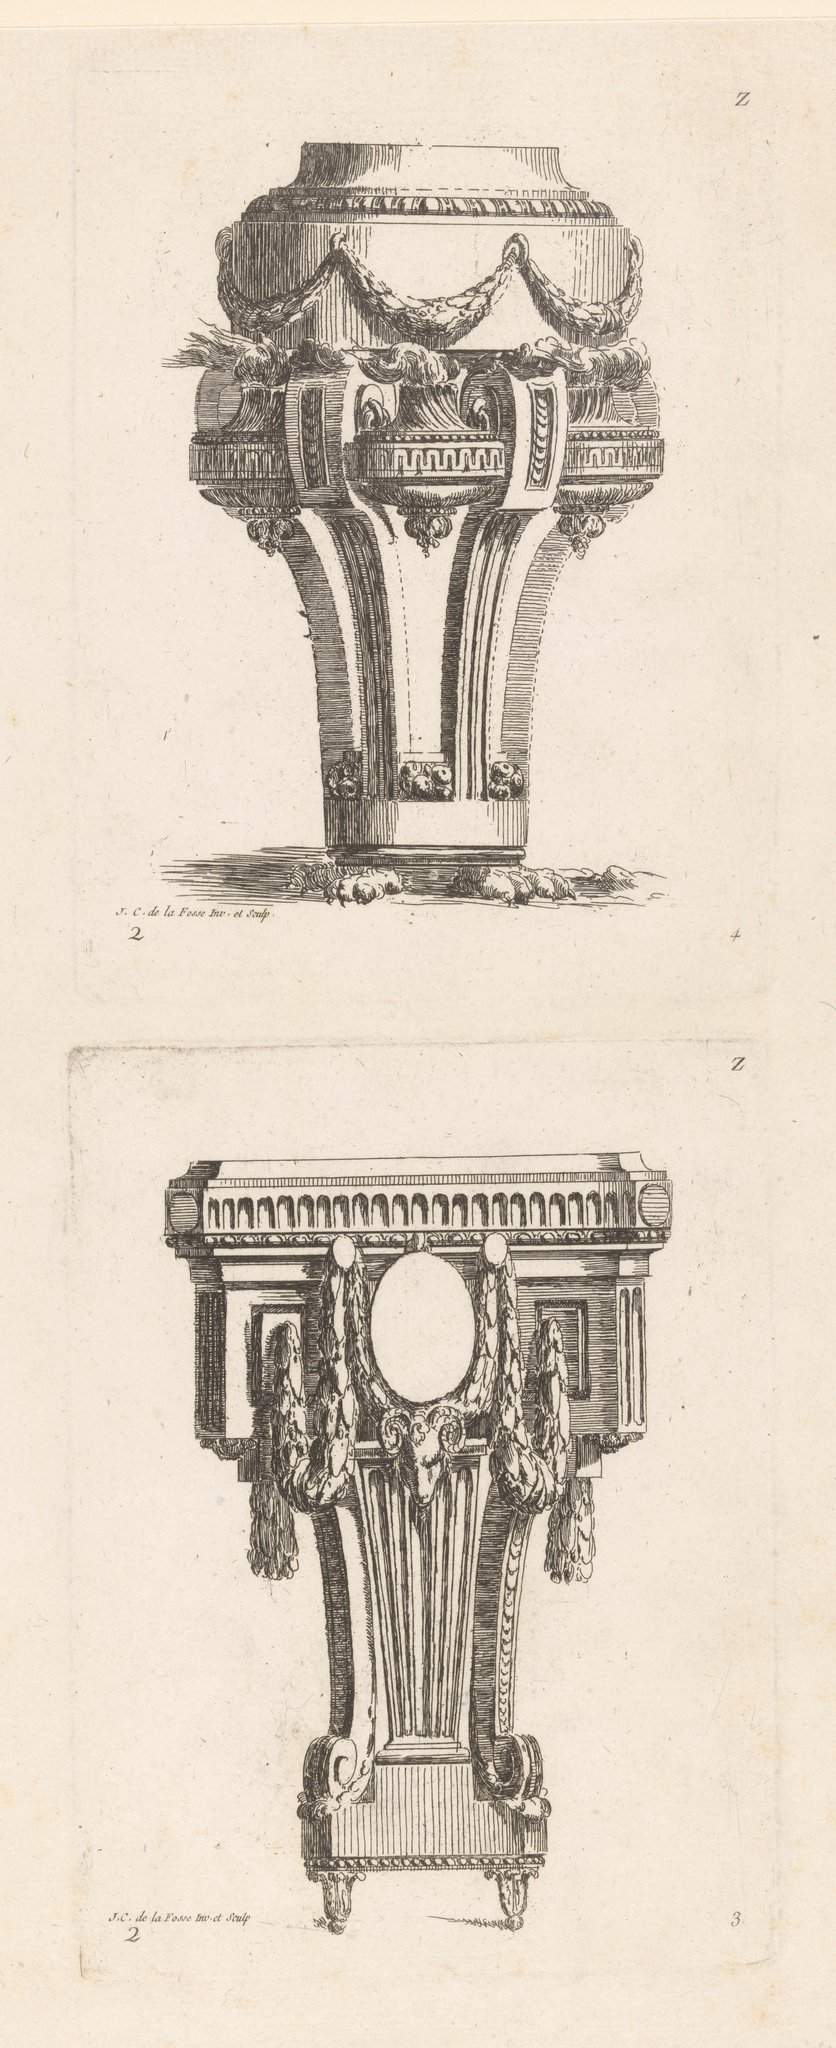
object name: ornament print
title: IIe Volume De l'Oeuvre de J. Ch. Delafosse (...)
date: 1771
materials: paper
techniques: etching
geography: paris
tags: table, incense-burner ~ scents, perfumes, ornament ~ festoon, garland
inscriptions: collector's mark: Lugt 2228, collector's mark: Lugt 2760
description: Twee tafels op een blad. Boven een tafel op leeuwenpoten met drie rookvaten en guirlandes. Onder een tafel met medaillon, ramskop en guirlandes. Links onder 2 genummerd.